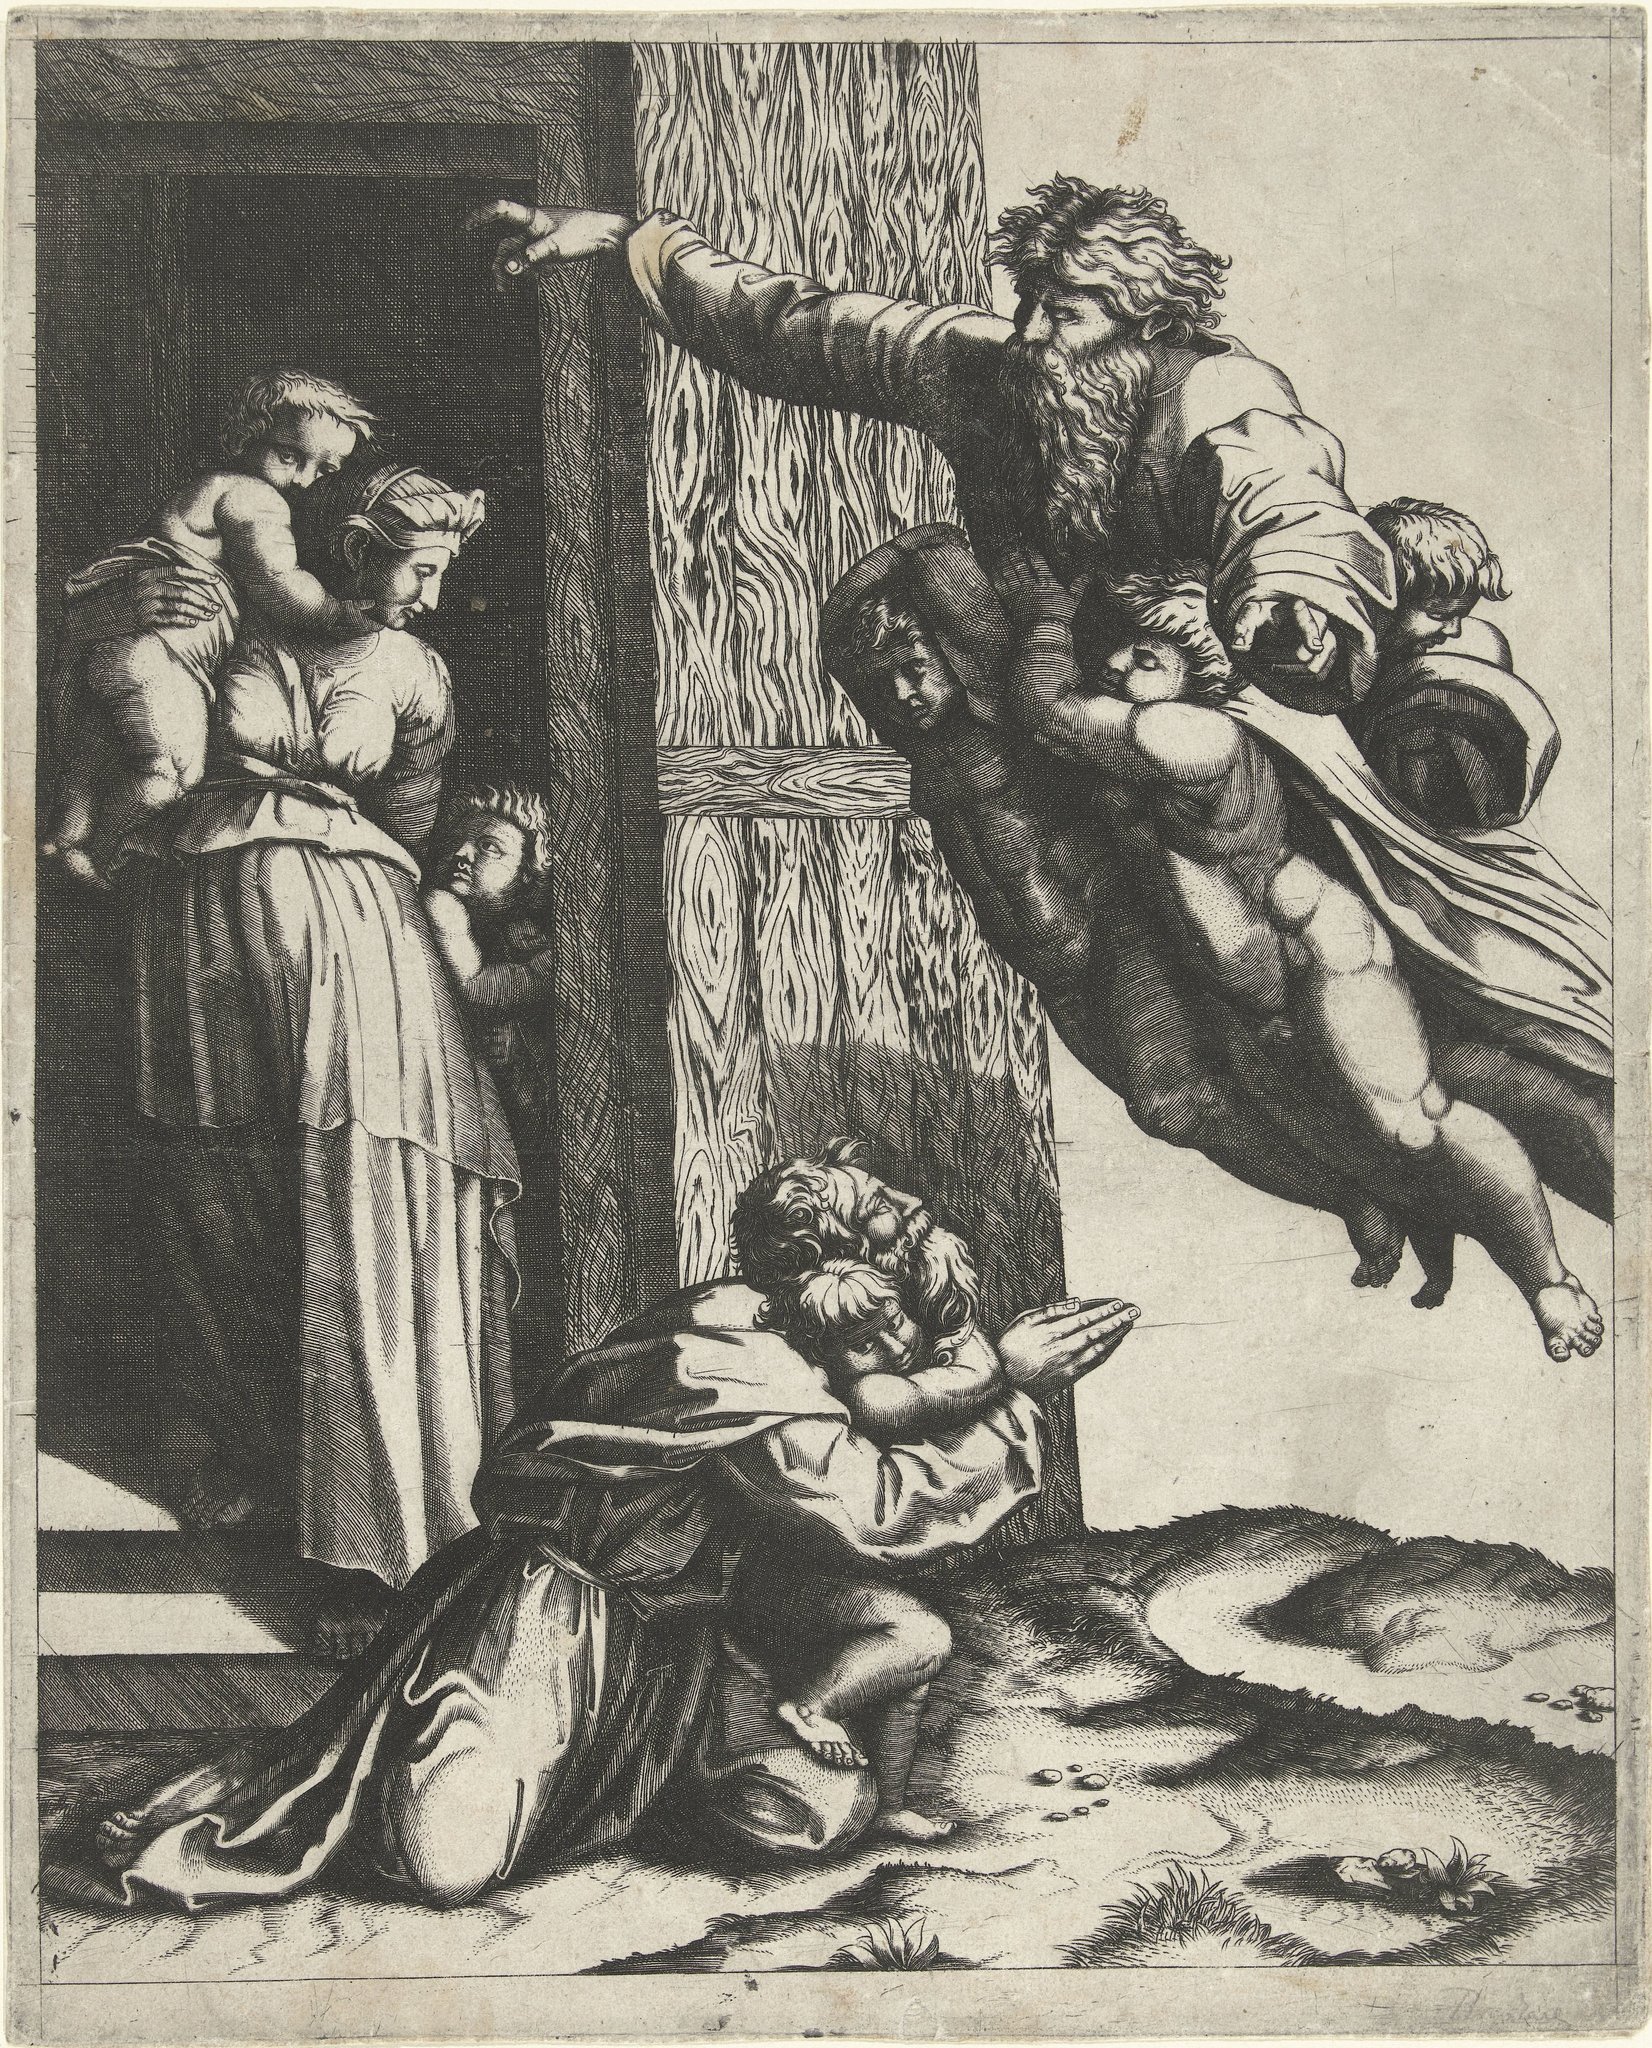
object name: print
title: God verschijnt aan Noach na de zondvloed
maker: Anonymous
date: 1513-1565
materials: paper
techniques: engraving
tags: god orders noah to disembark and opens the ark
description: Kopie in spiegelbeeld naar prent van Marcantonio Raimondi. Met name de figuren in de compositie baseerde Raimondi op een fresco van Raphael in de Stanza d'Eliodoro te Rome (Shoemaker 1981, p. 104).